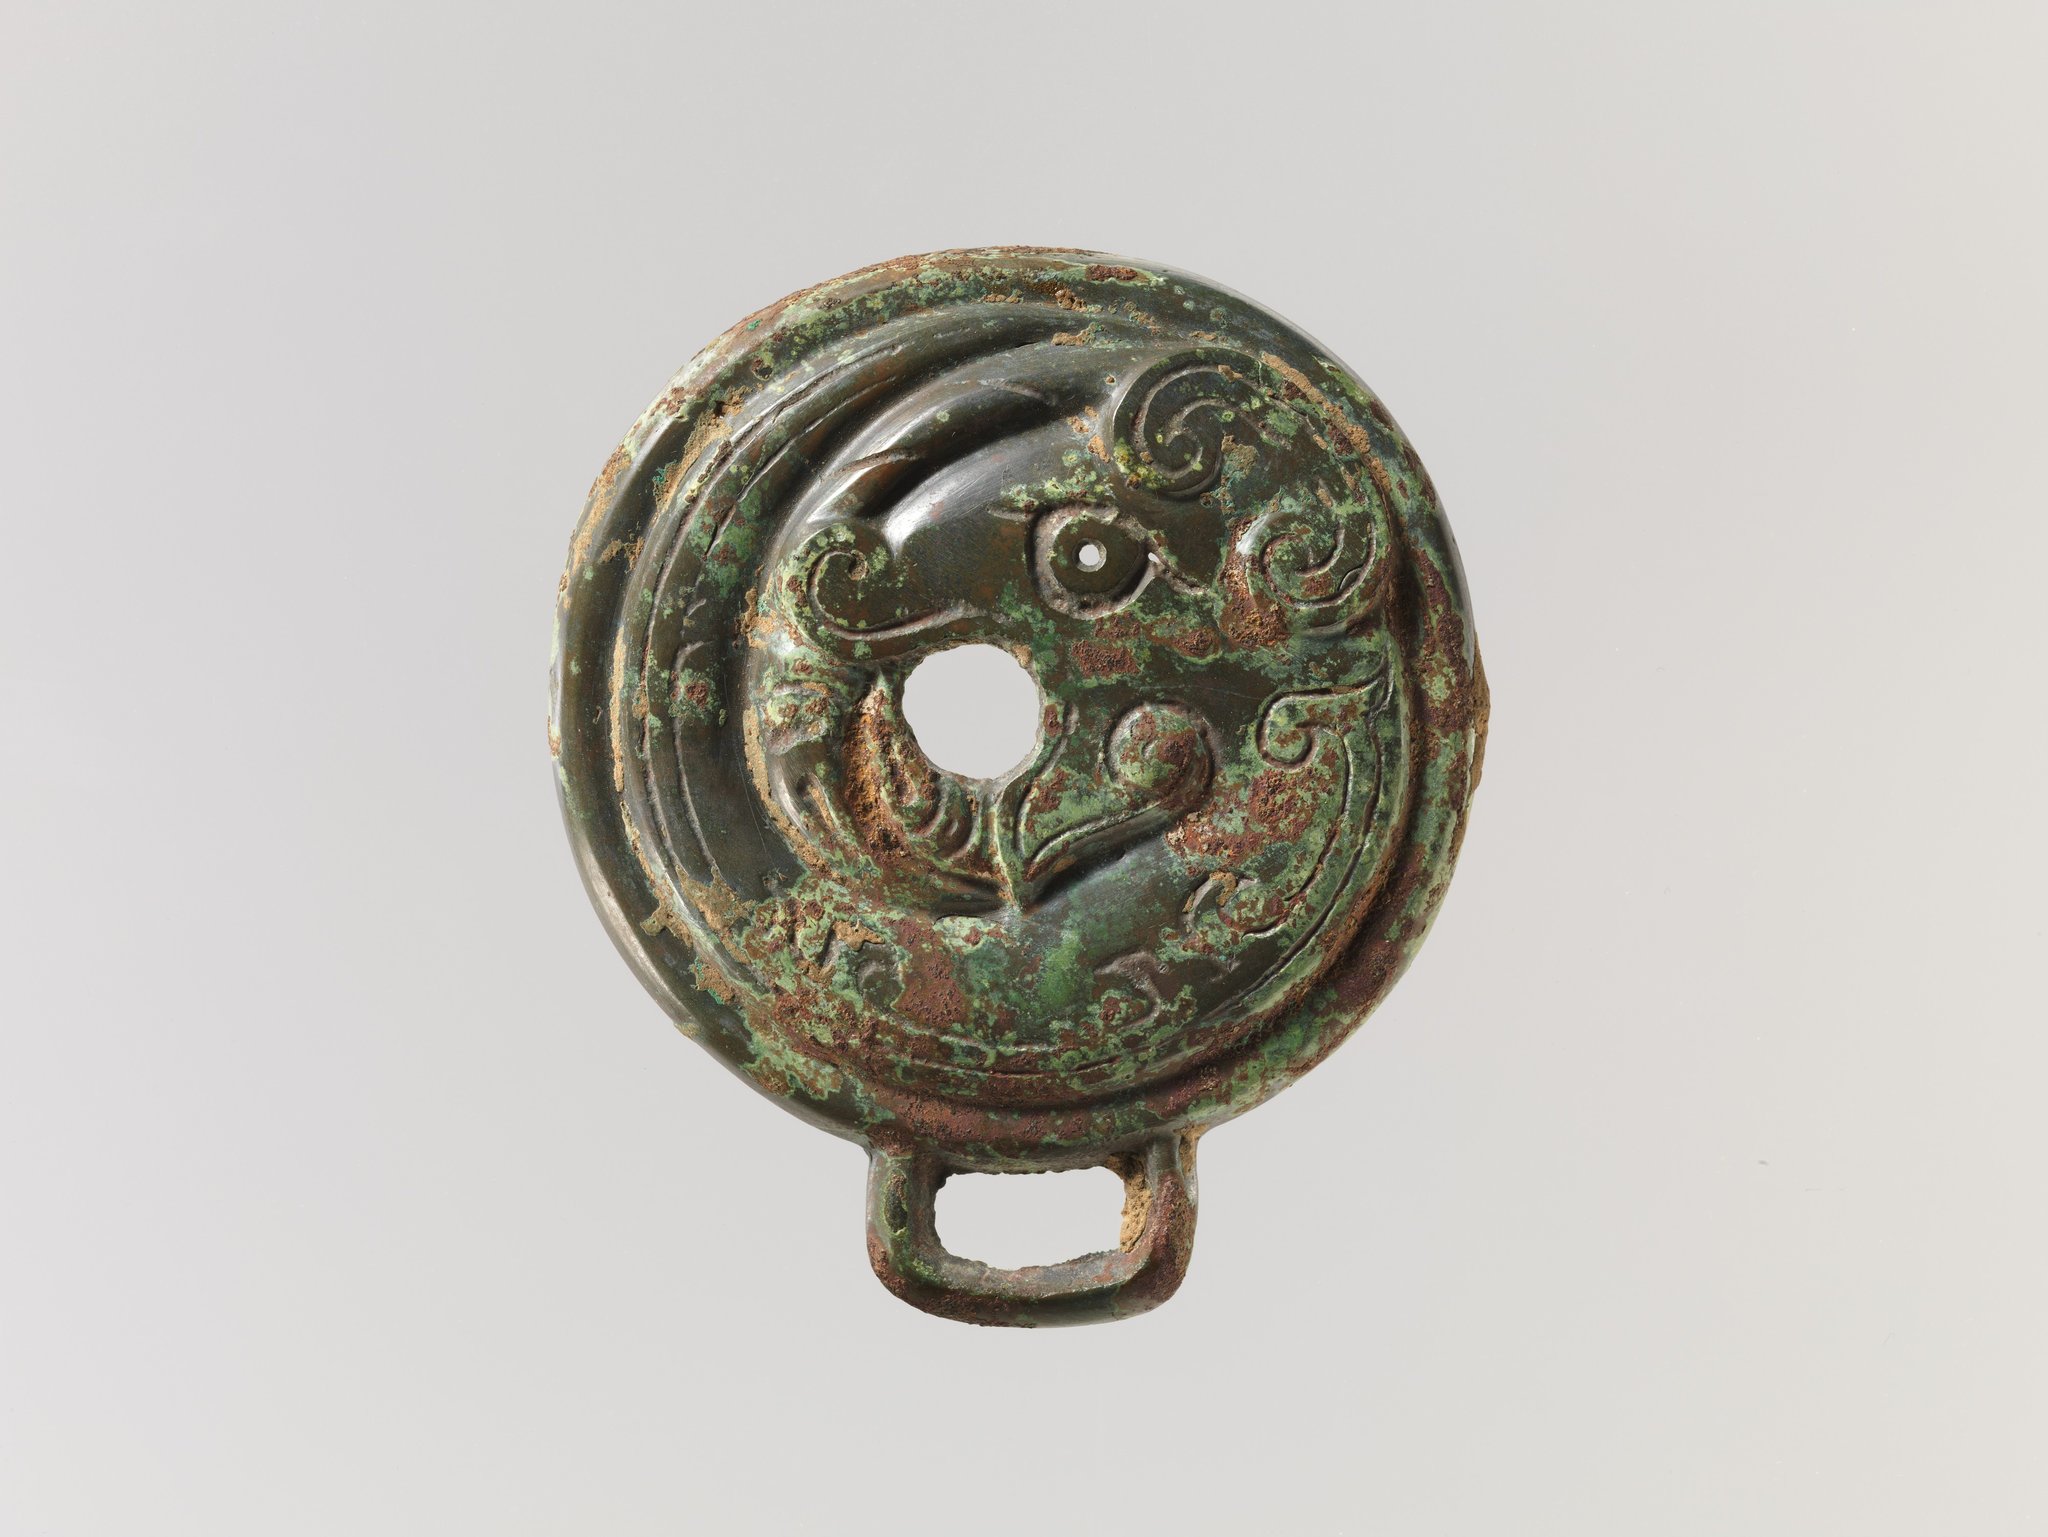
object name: bridle cheekpiece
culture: chinese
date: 1100-901 BCE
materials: bronze